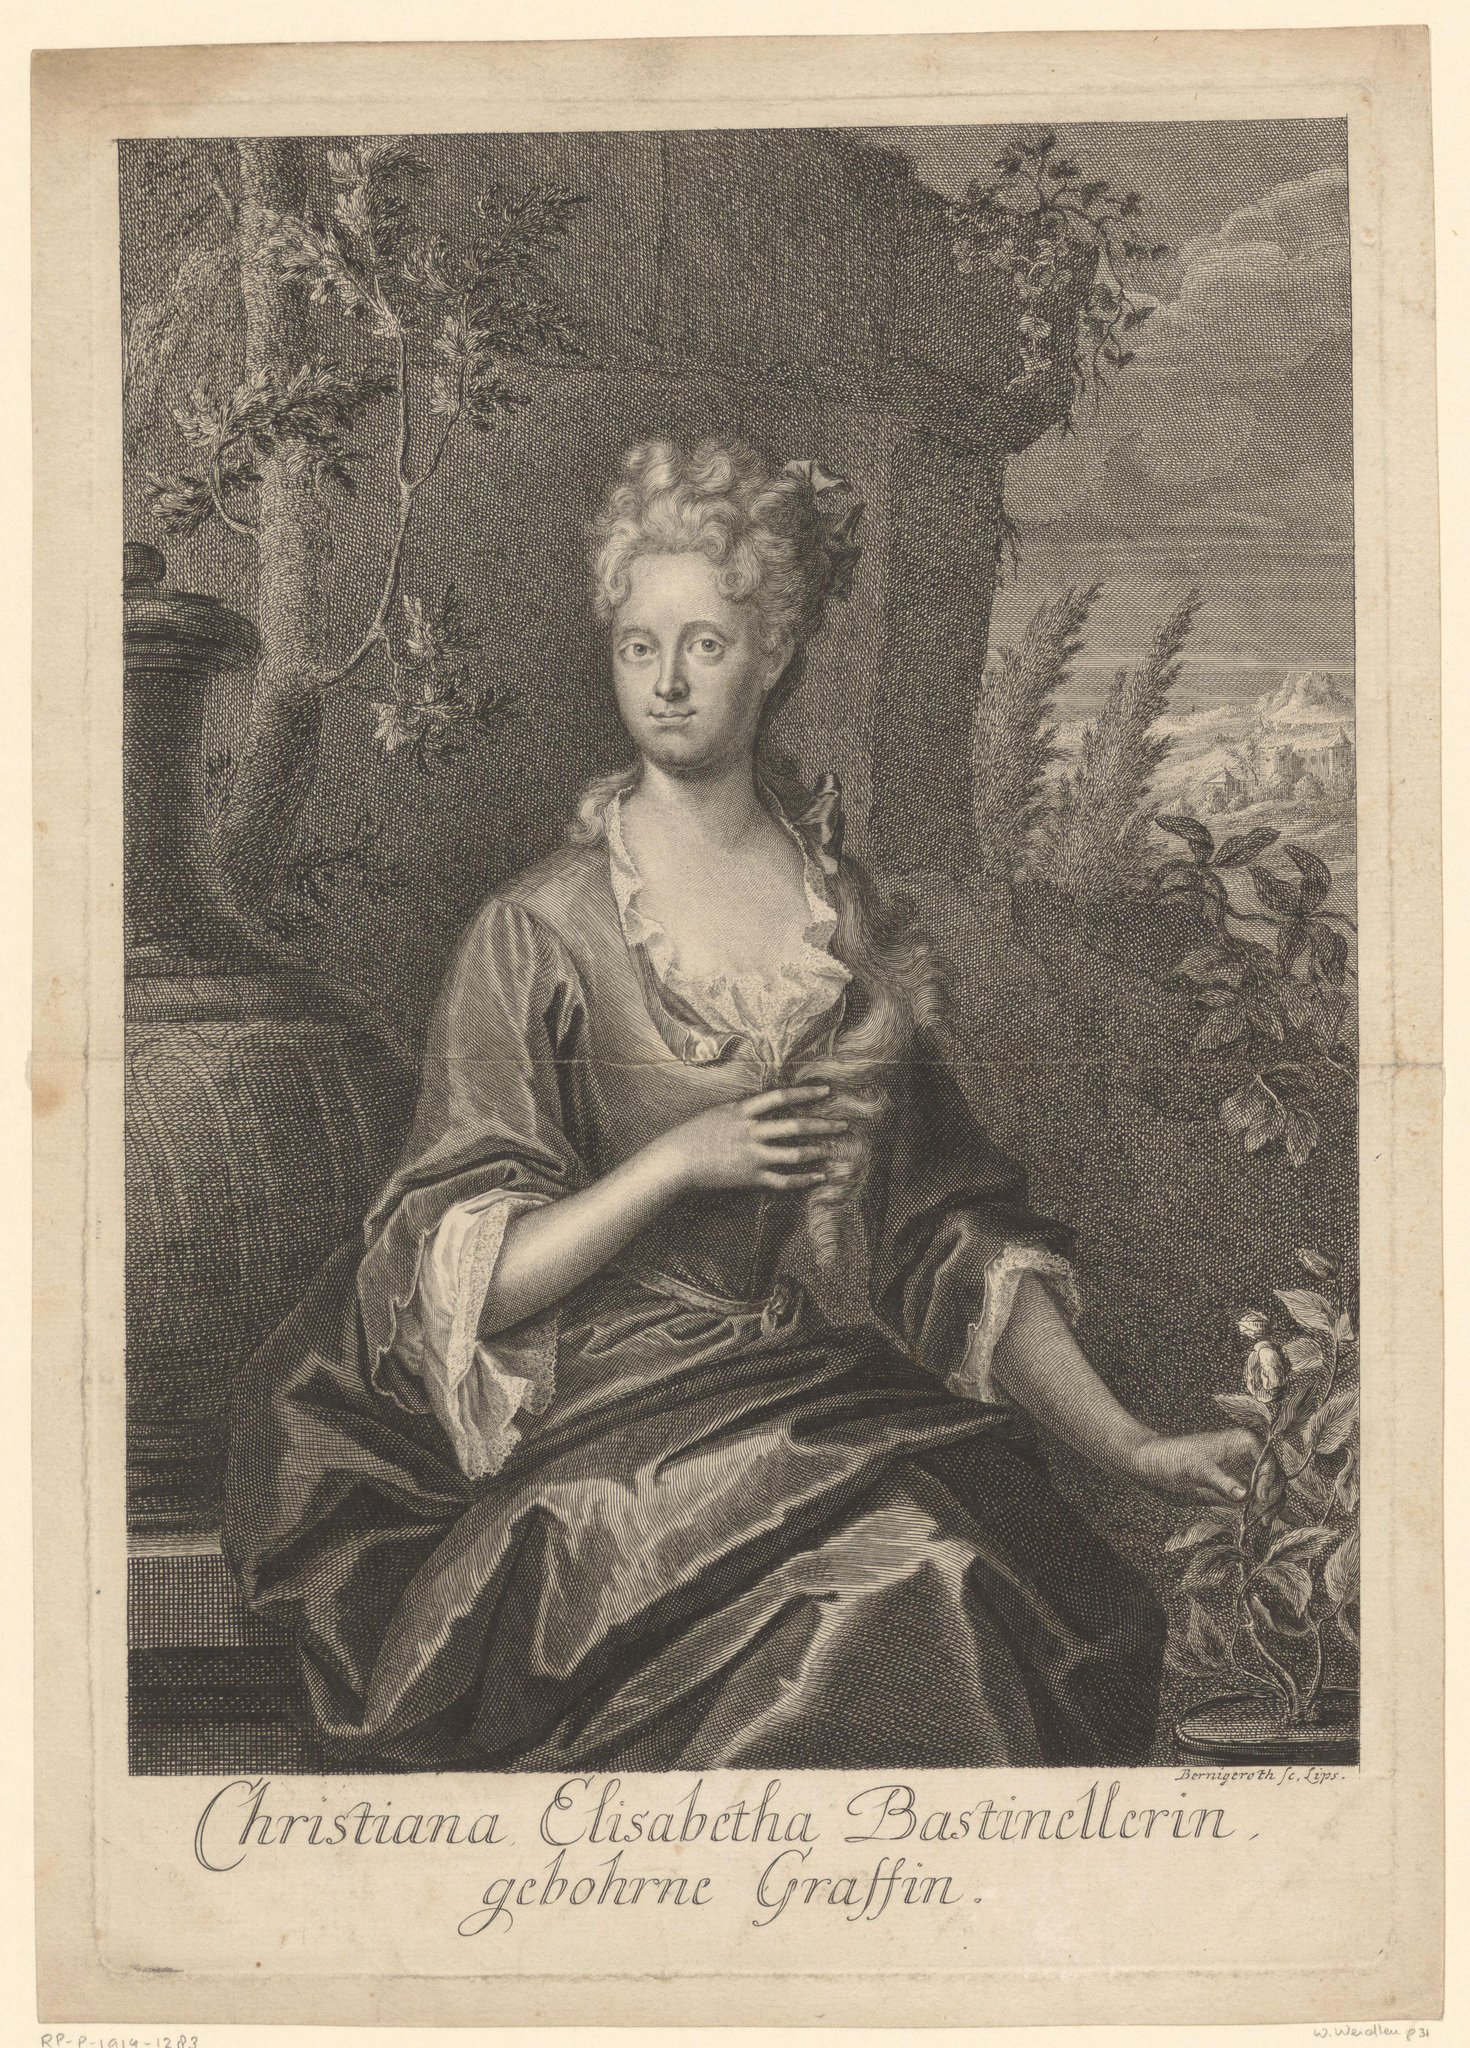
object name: print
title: Portret van Elisabeth Charlotte Mylius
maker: martin bernigeroth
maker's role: print maker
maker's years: 1670-1733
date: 1720-1733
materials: paper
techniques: engraving, etching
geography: leipzig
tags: historical persons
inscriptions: collector's mark: Lugt 2228